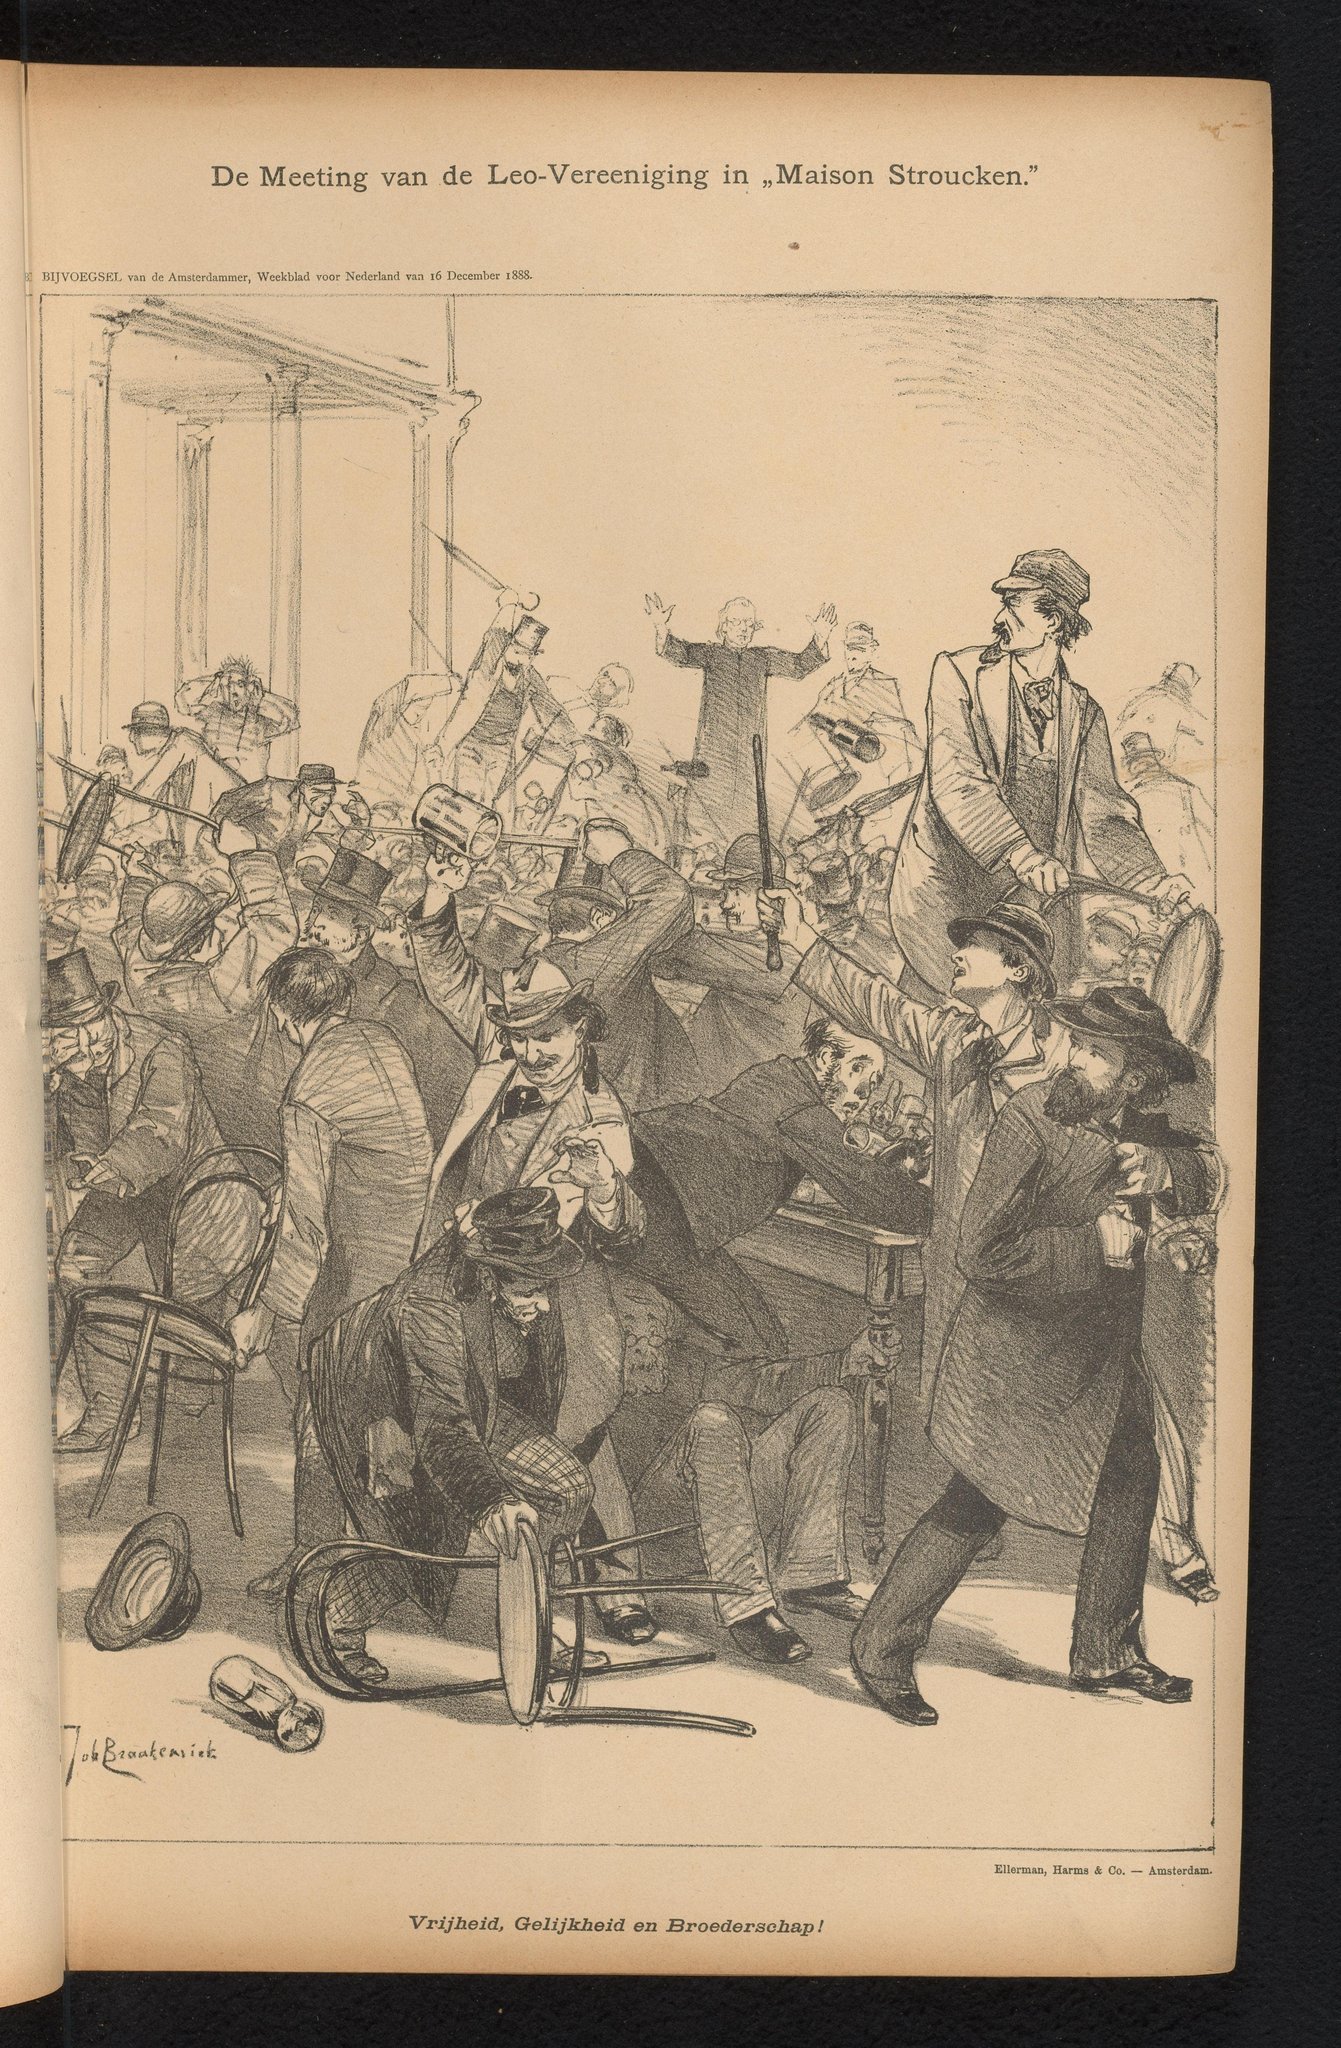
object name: cartoon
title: De Meeting van de Leo-Vereeniging in "Maison Stroucken." / Vrijheid, Geijkheid en Broederschap!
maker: johan braakensiek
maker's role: draughtsman, print maker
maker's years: 1858-1940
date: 1888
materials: paper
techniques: lithograph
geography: netherlands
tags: club, meeting place, fighting, political caricatures and satires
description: Een bijeenkomst van de Leo-Vereniging (de Nederlandse onderafdeling van de Lions Club International) in Maison Stroucken ontaardt in een grote vechtpartij. Theatergebouw Maison Stroucken werd later Theater Bellevue aan de Marnixstraat te Amsterdam.